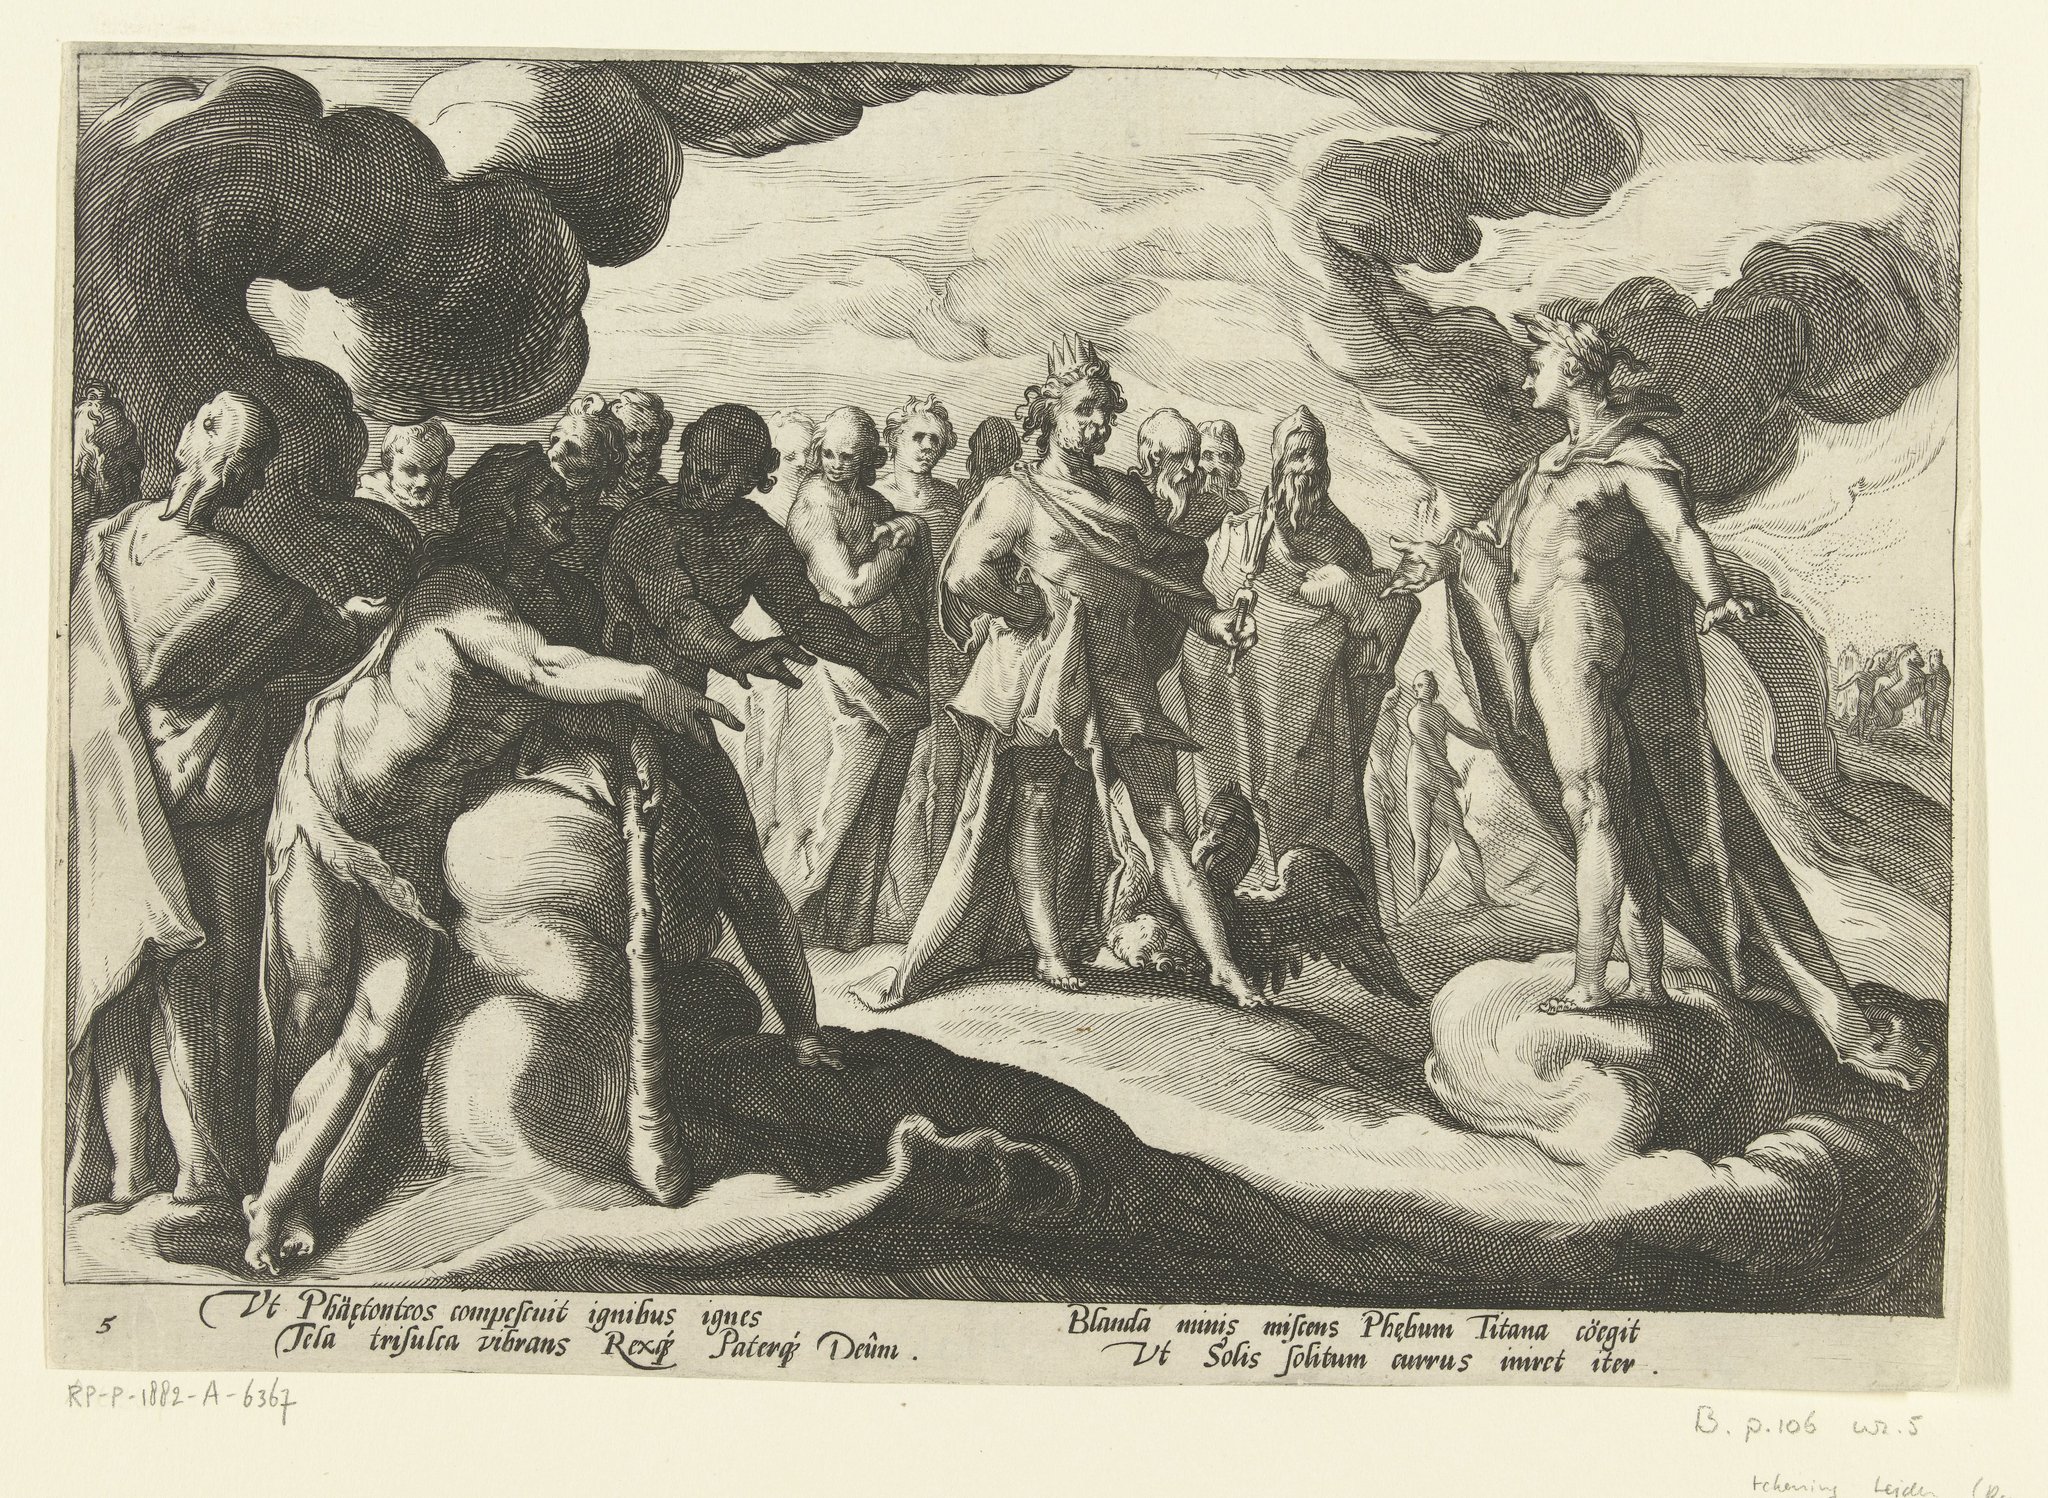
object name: print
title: Ovidius' Metamorfosen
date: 1590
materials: paper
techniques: engraving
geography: haarlem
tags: the gods beg apollo (sol), mourning for the death of phaethon, to drive his chariot again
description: Na de dood van Phaëthon hult de zonnegod zich in rouw en onthoudt hij de aarde het daglicht. De goden, onder wie Jupiter, verzoeken hem om weer in zijn kar langs de hemel te gaan rijden. Onder de voorstelling twee keer twee regels Latijnse tekst. Deze prent is onderdeel van een serie van 52 prenten die verhalen uit Ovidius' Metamorfosen verbeelden. Deze serie valt uiteen in drie genummerde reeksen: twee van 20 prenten en één van 12 prenten. Deze prent behoort tot de tweede reeks.